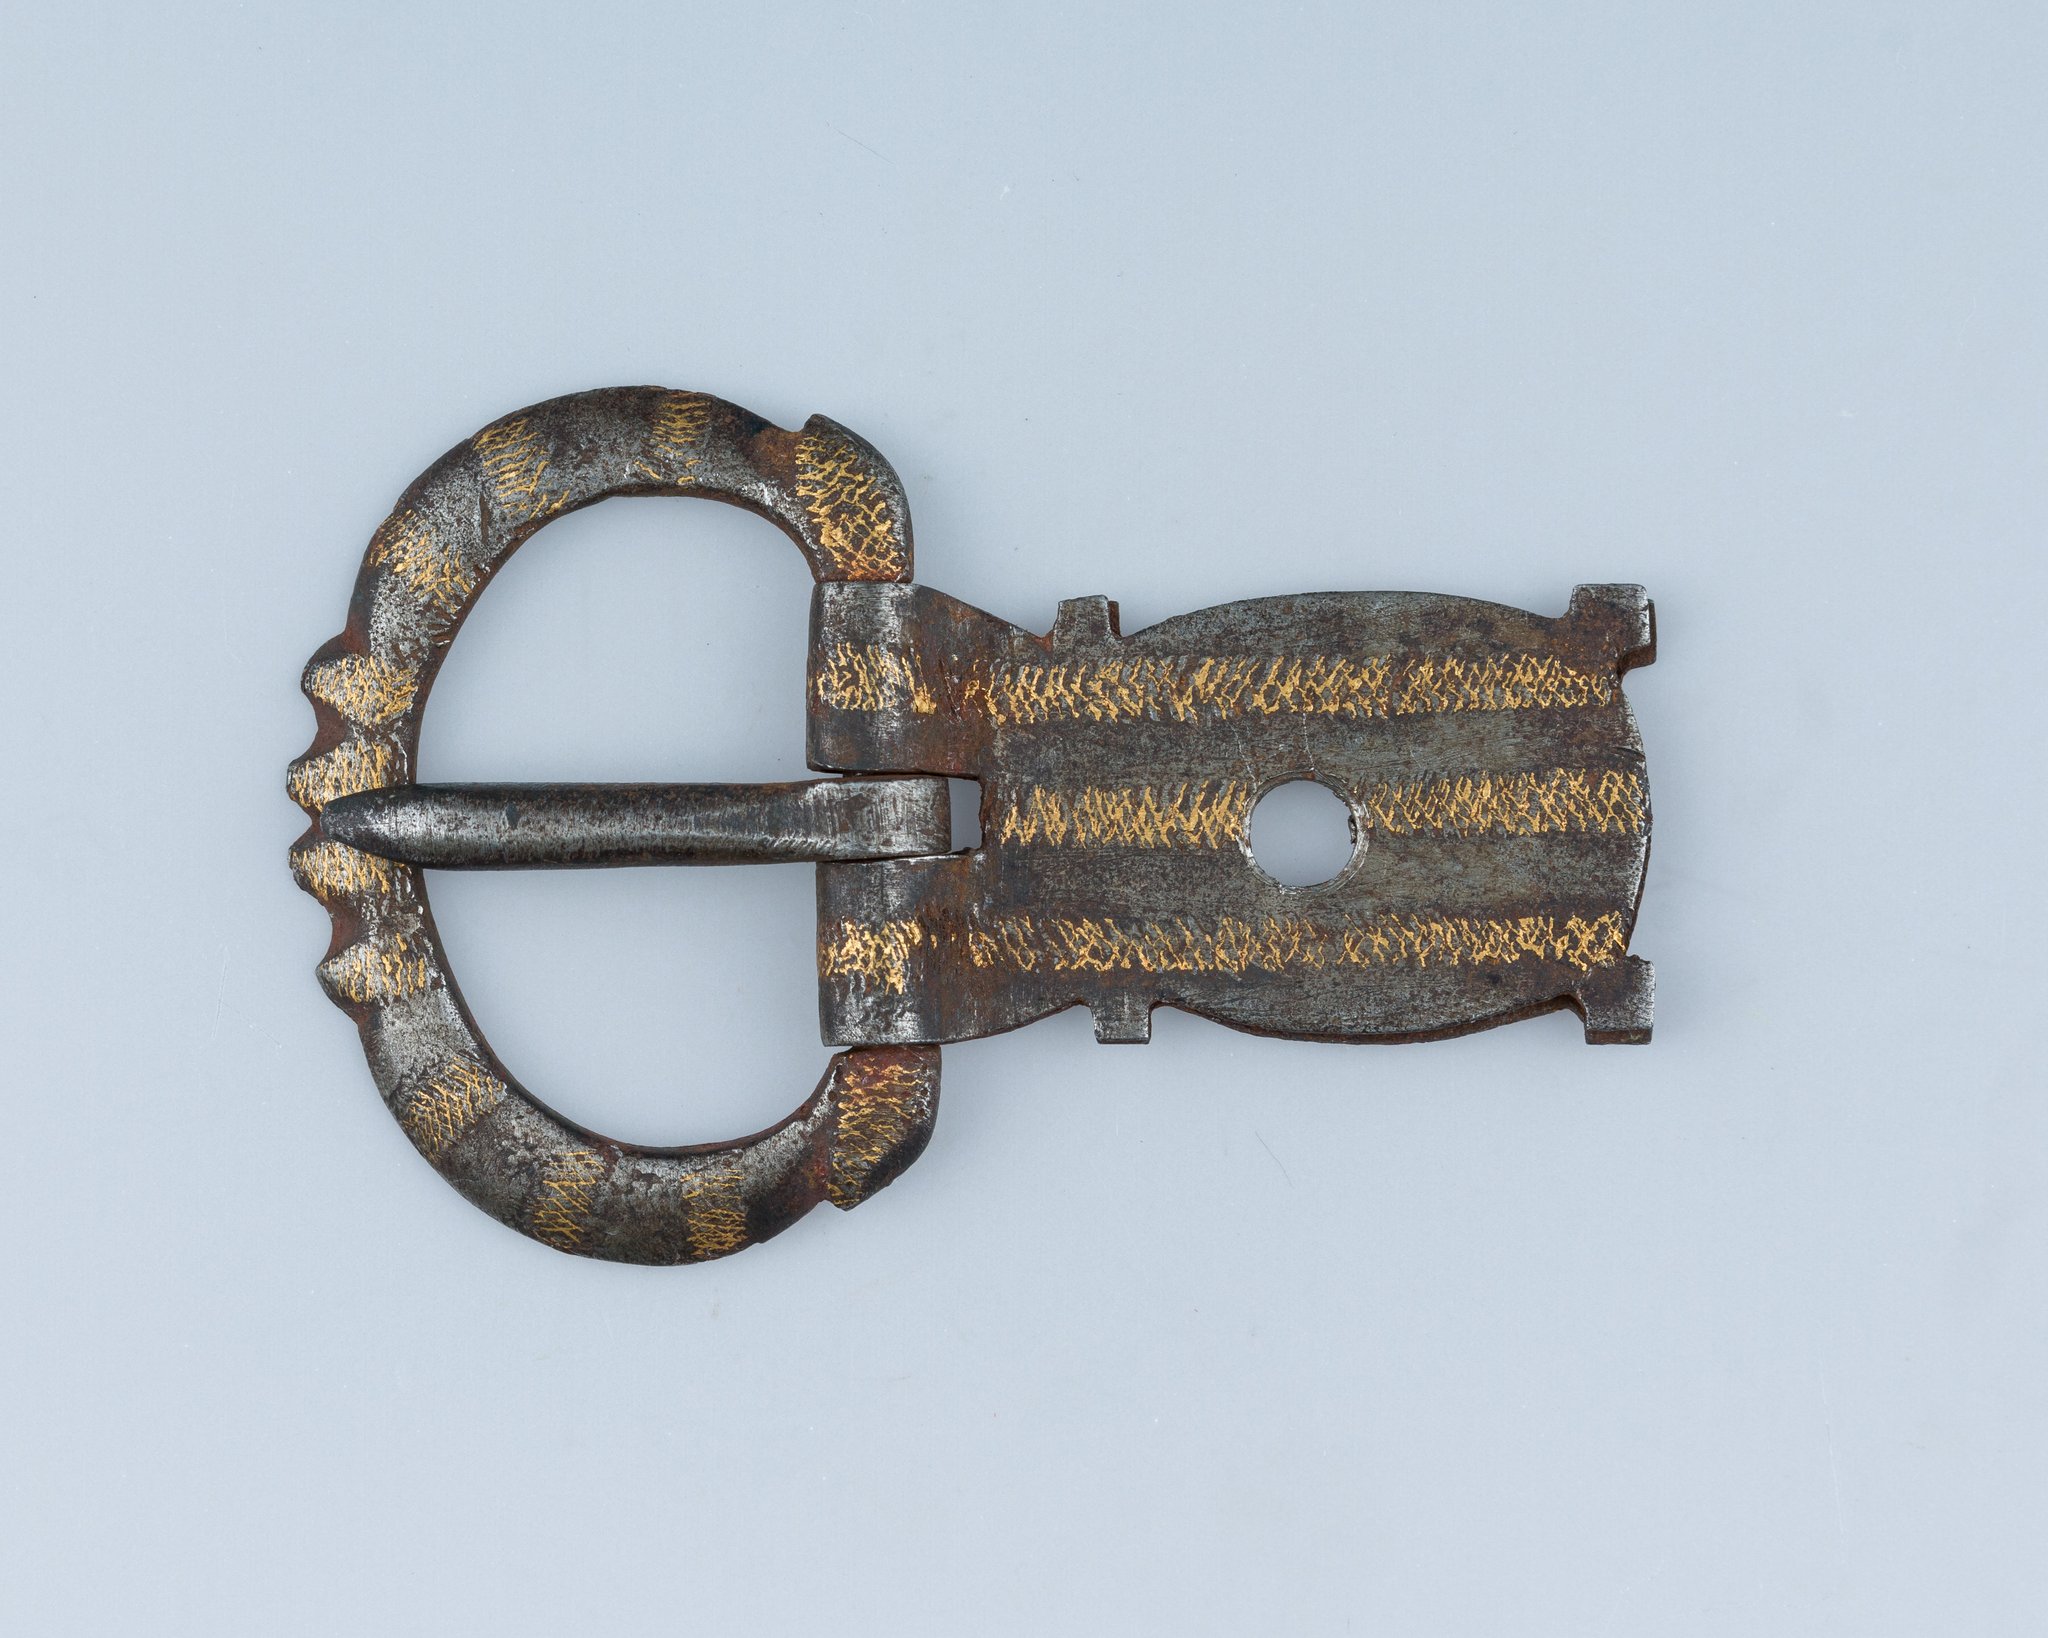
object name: buckle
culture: italian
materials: steel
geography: italy